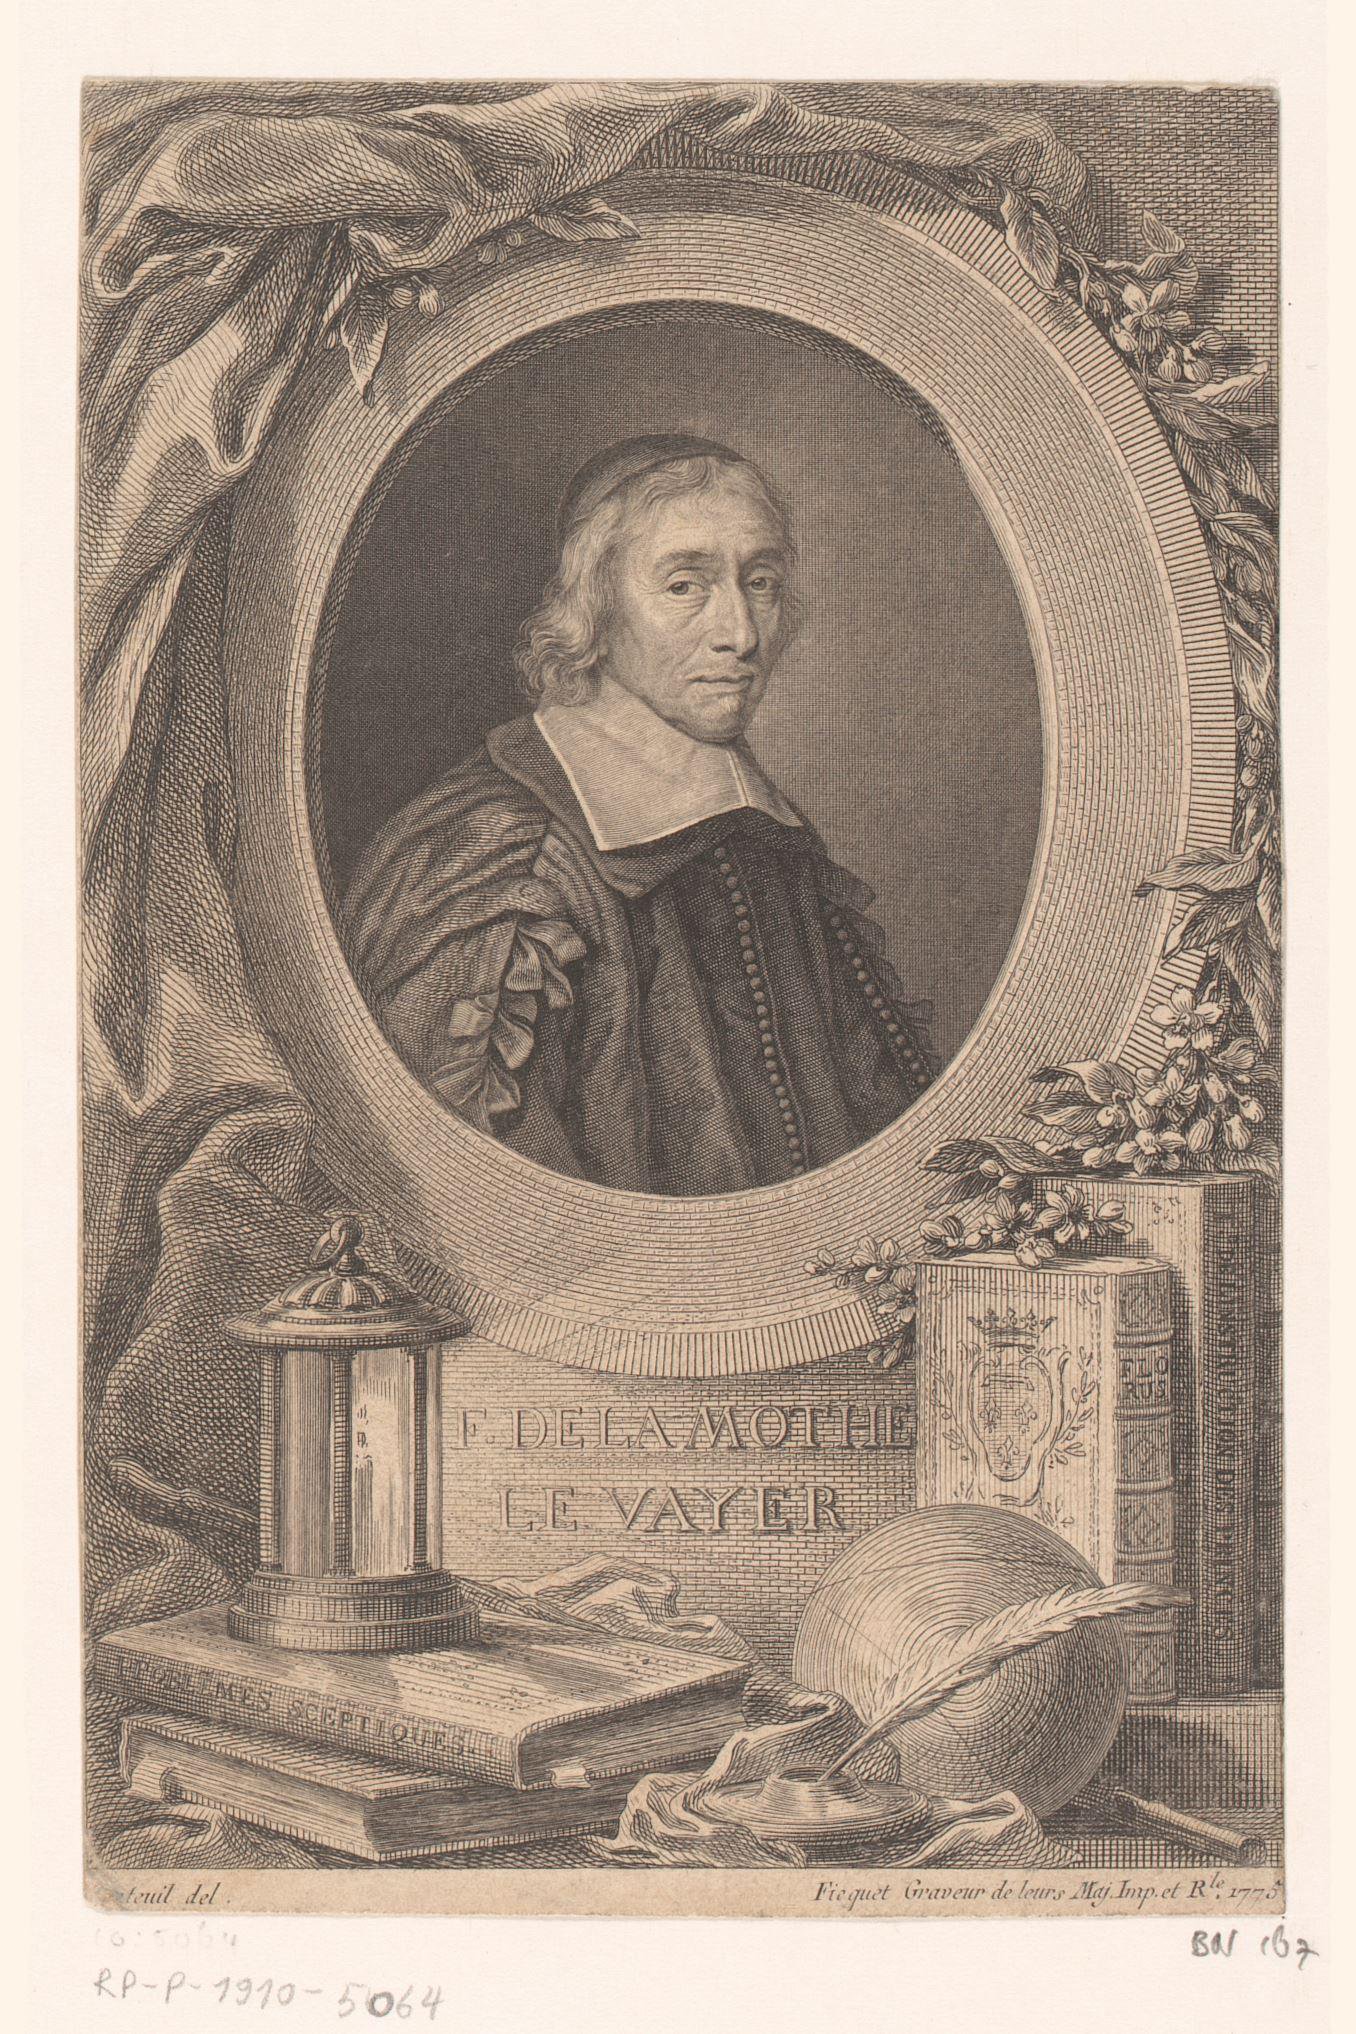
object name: print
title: Portret van François de La Mothe Le Vayer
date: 1755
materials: paper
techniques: engraving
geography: france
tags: paris, ornament ~ medallion, historical persons, portrait of a writer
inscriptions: collector's mark: Lugt 2228